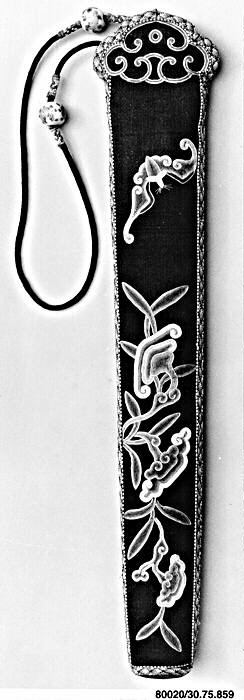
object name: fan holder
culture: chinese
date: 1701-1900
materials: silk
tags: bats,flowers